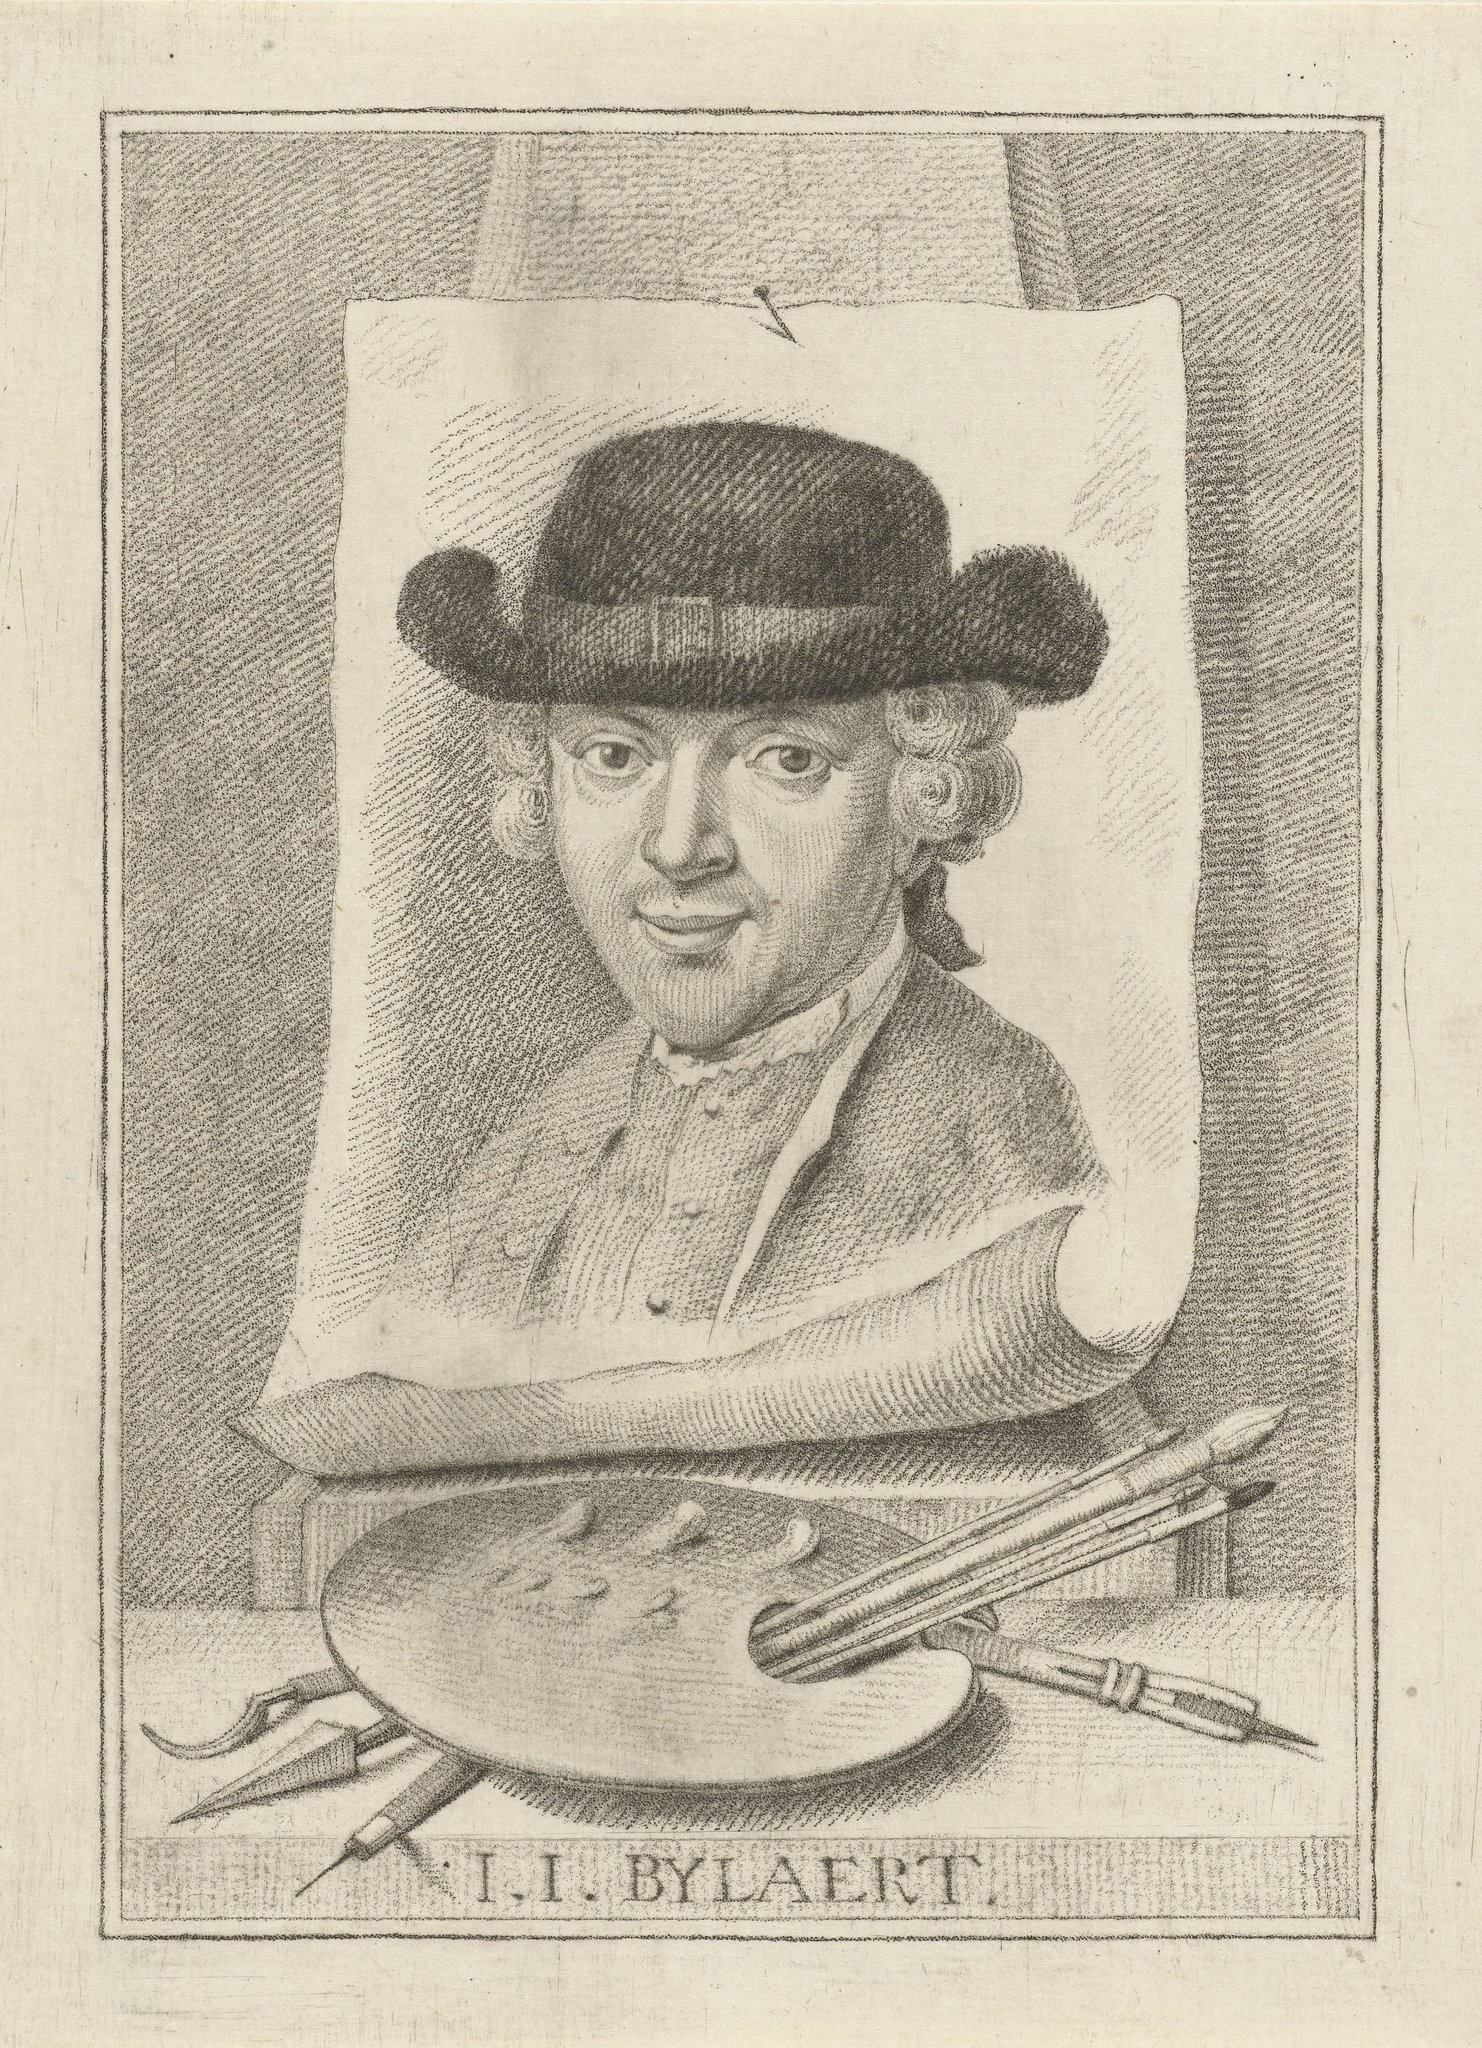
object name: print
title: Portret van J.J. Bylaert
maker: joannis jacobus bijlaert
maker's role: draughtsman, print maker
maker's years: 1734-1809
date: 1749-1809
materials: paper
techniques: printmaking, etching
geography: leiden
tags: rotterdam, leiden, print maker, joannis jacobus bijlaert, palette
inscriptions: collector's mark: Lugt 2228, collector's mark: Lugt 2760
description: Zelfportret van de prentmaker Joannis Jacobus Bijlaert (1734-1809), weergegeven als tekening welke met een spijker op een schildersezel is bevestigd; op de voorgrond een schilderspalet.